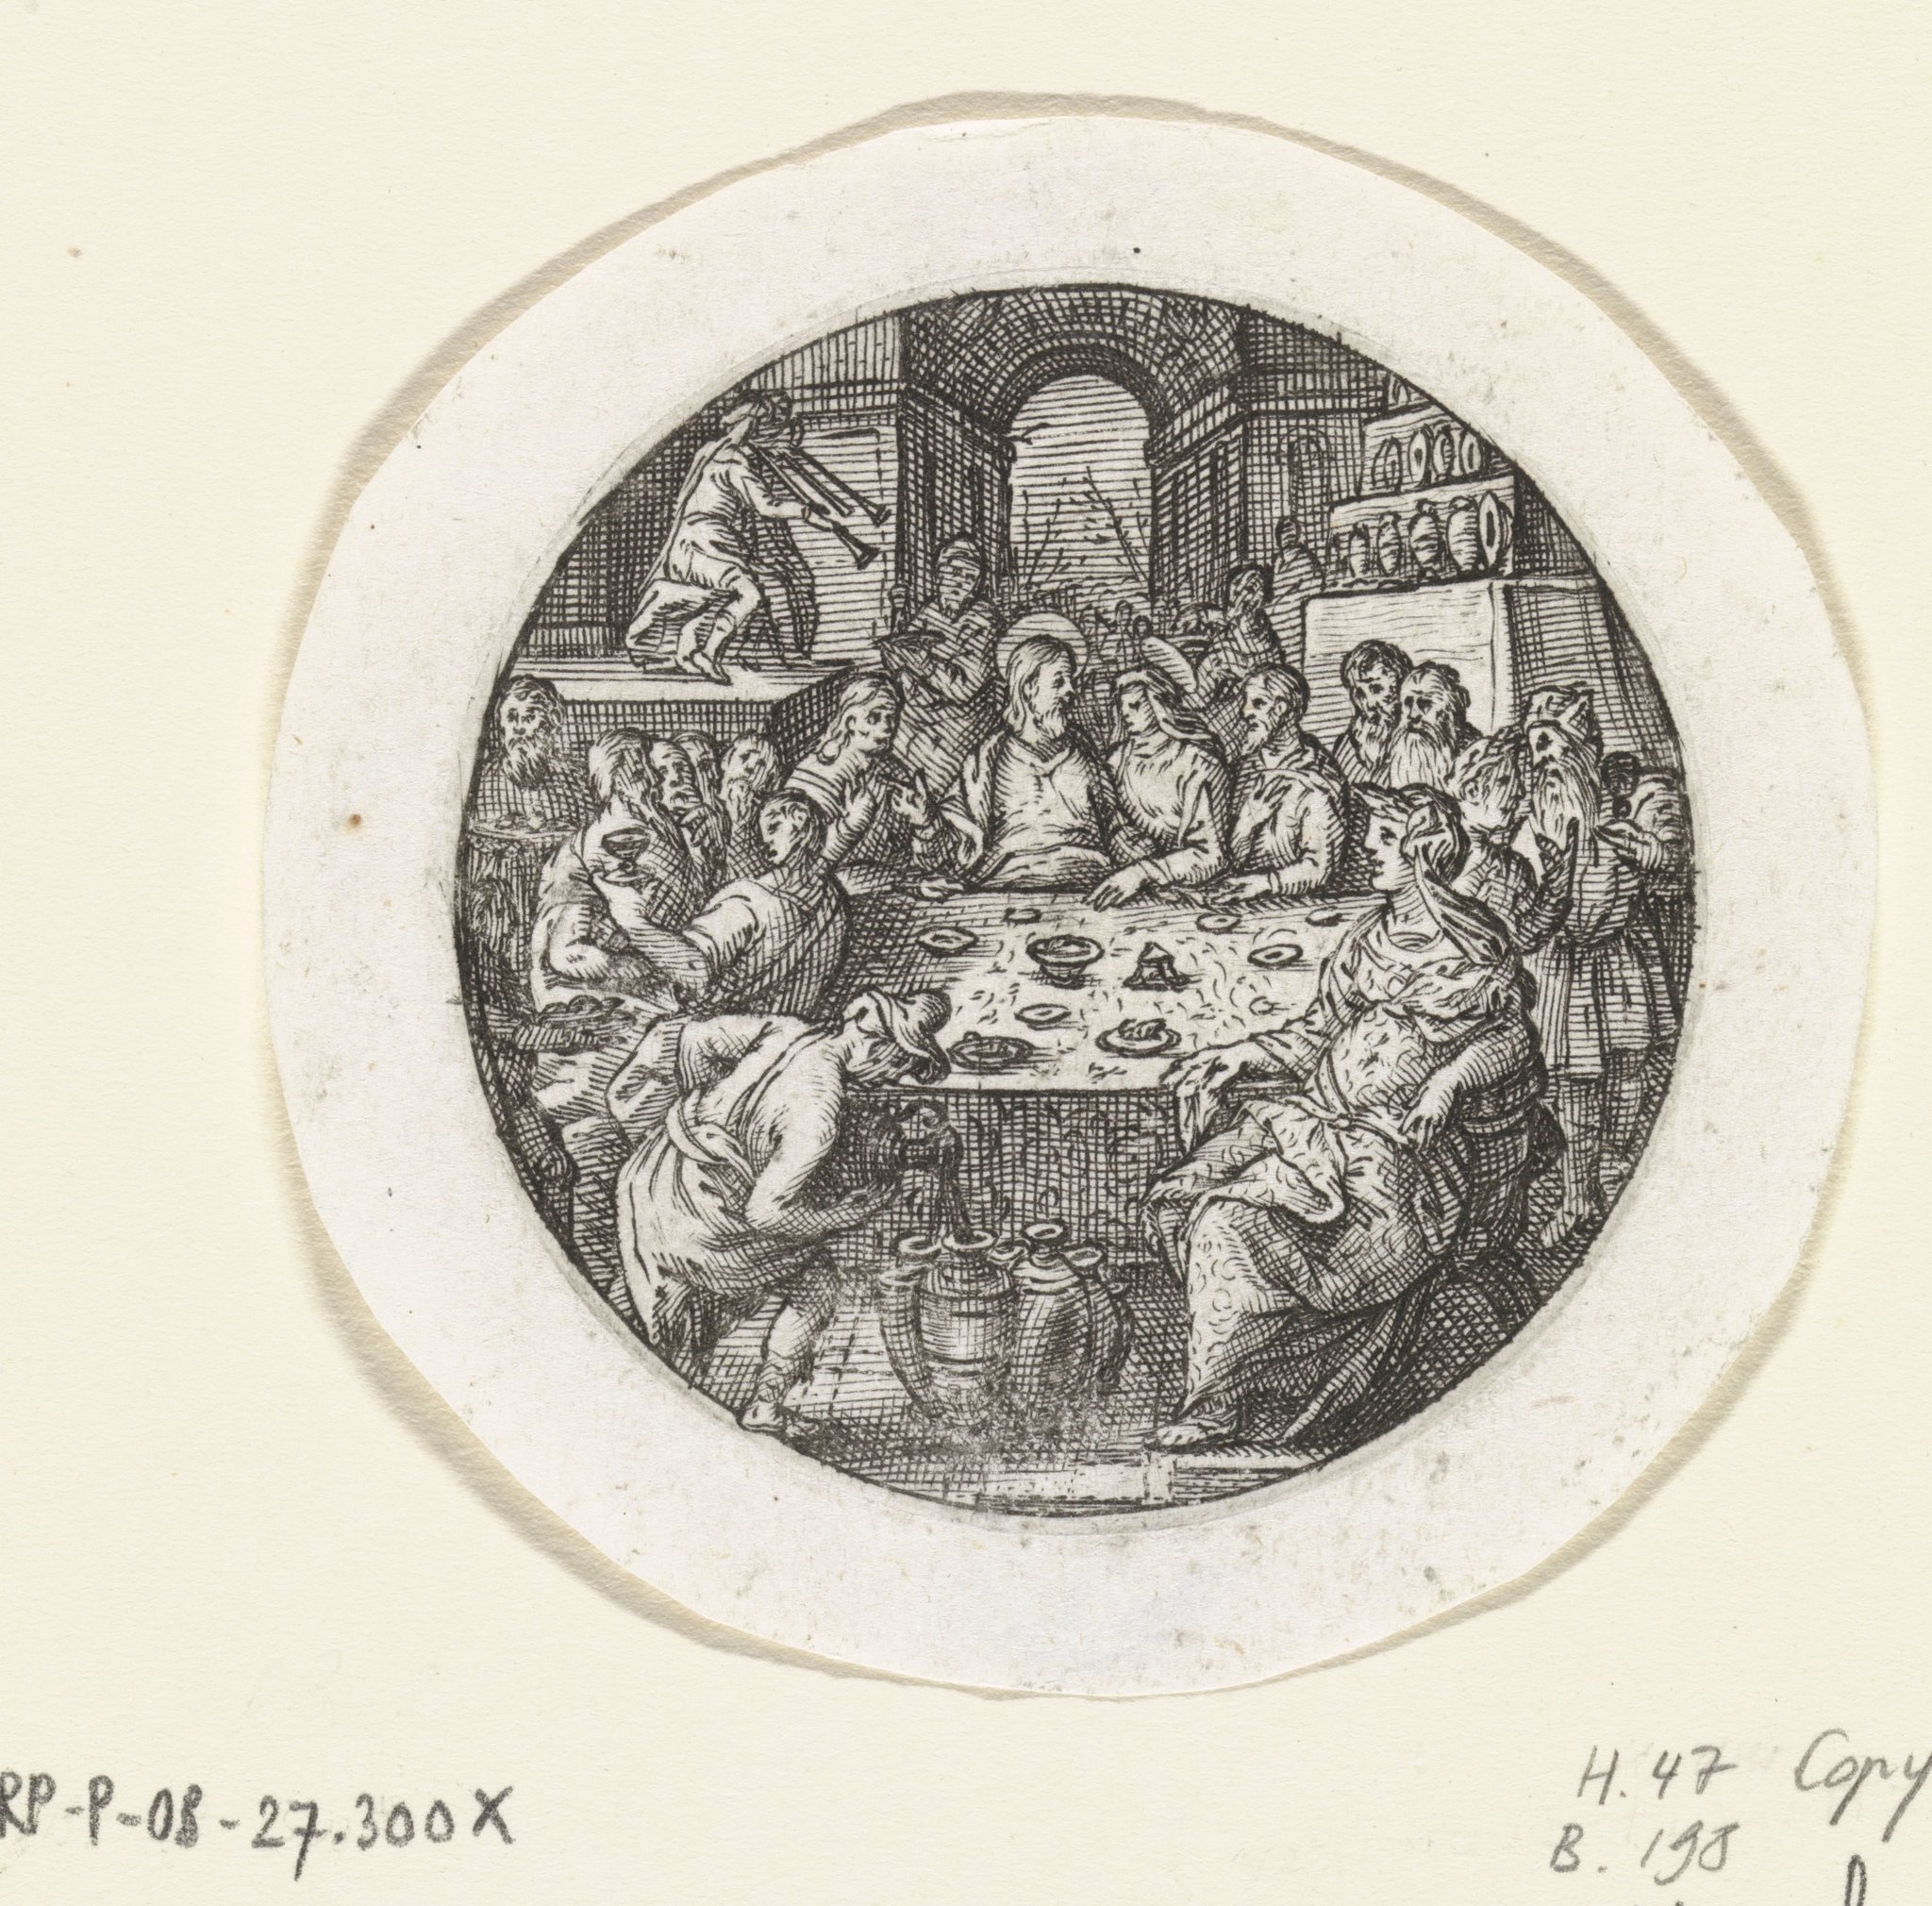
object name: print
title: Bruiloft te Kana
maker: dirck strijcker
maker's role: draughtsman, print maker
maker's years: 1588-1677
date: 1601-1651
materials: paper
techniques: engraving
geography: northern netherlands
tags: the marriage-feast at cana (john 2:1-11)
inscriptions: collector's mark: Lugt 2228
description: Christus en Maria aan een tafel, omringd door vele gasten. Op de voorgrond worden op Christus' aanwijzingen zes stenen vaten gevuld met water, dat in wijn zal veranderen.